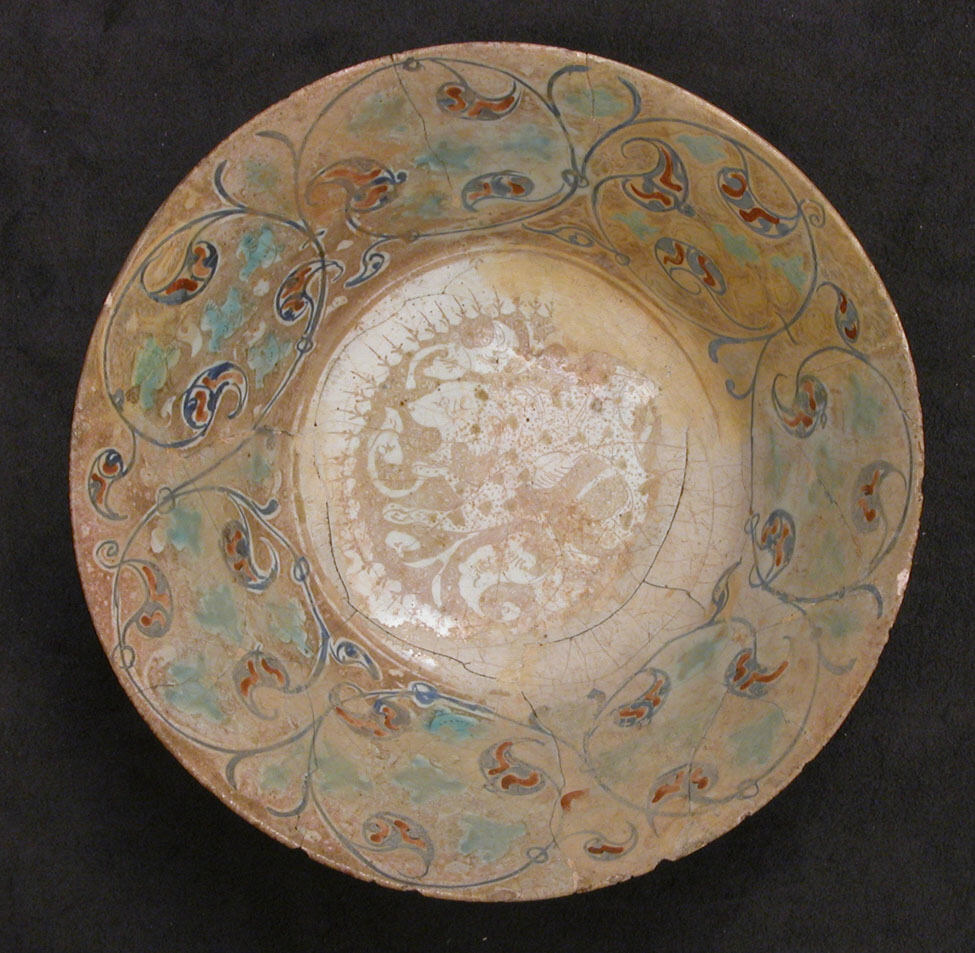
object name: bowl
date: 1201-1300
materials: earthenware, tin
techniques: enamel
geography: iran